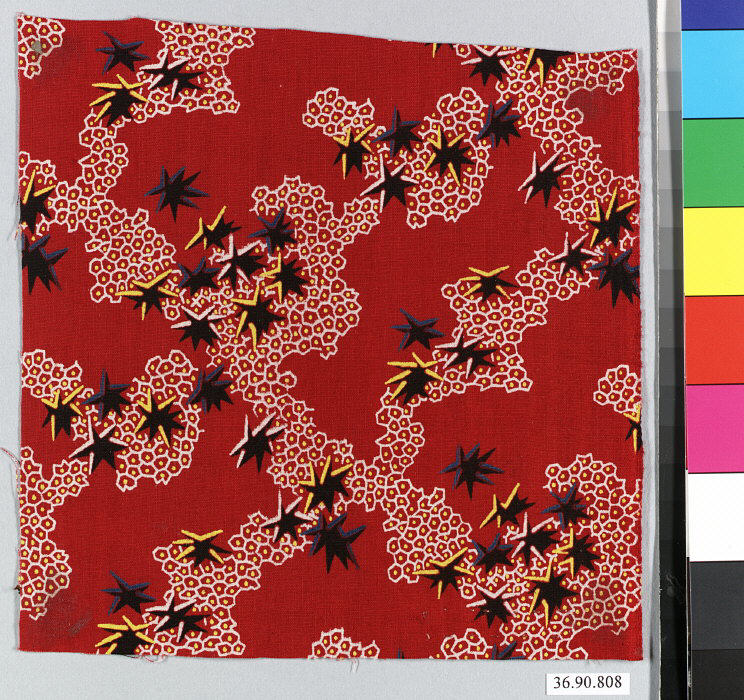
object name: piece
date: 1867-1900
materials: cotton